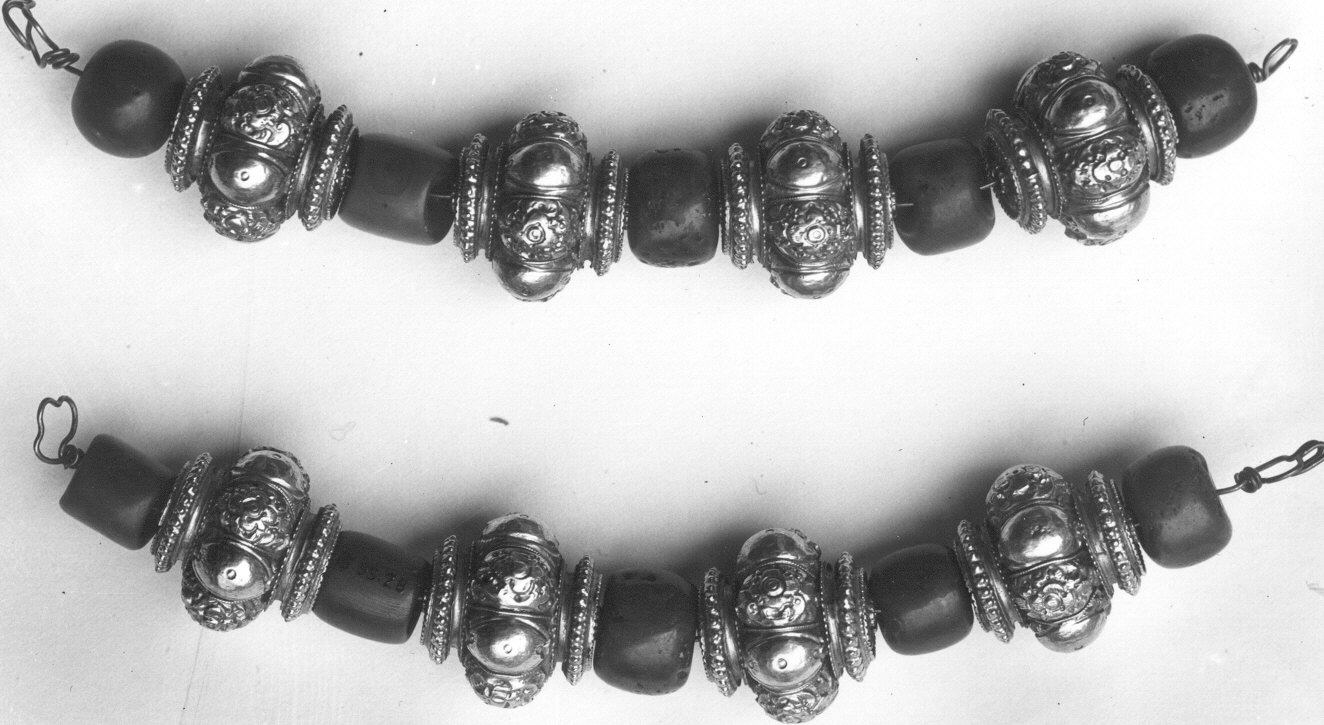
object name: bracelet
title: Bracelet, One of a Pair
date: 1701-1900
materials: gold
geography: southern india